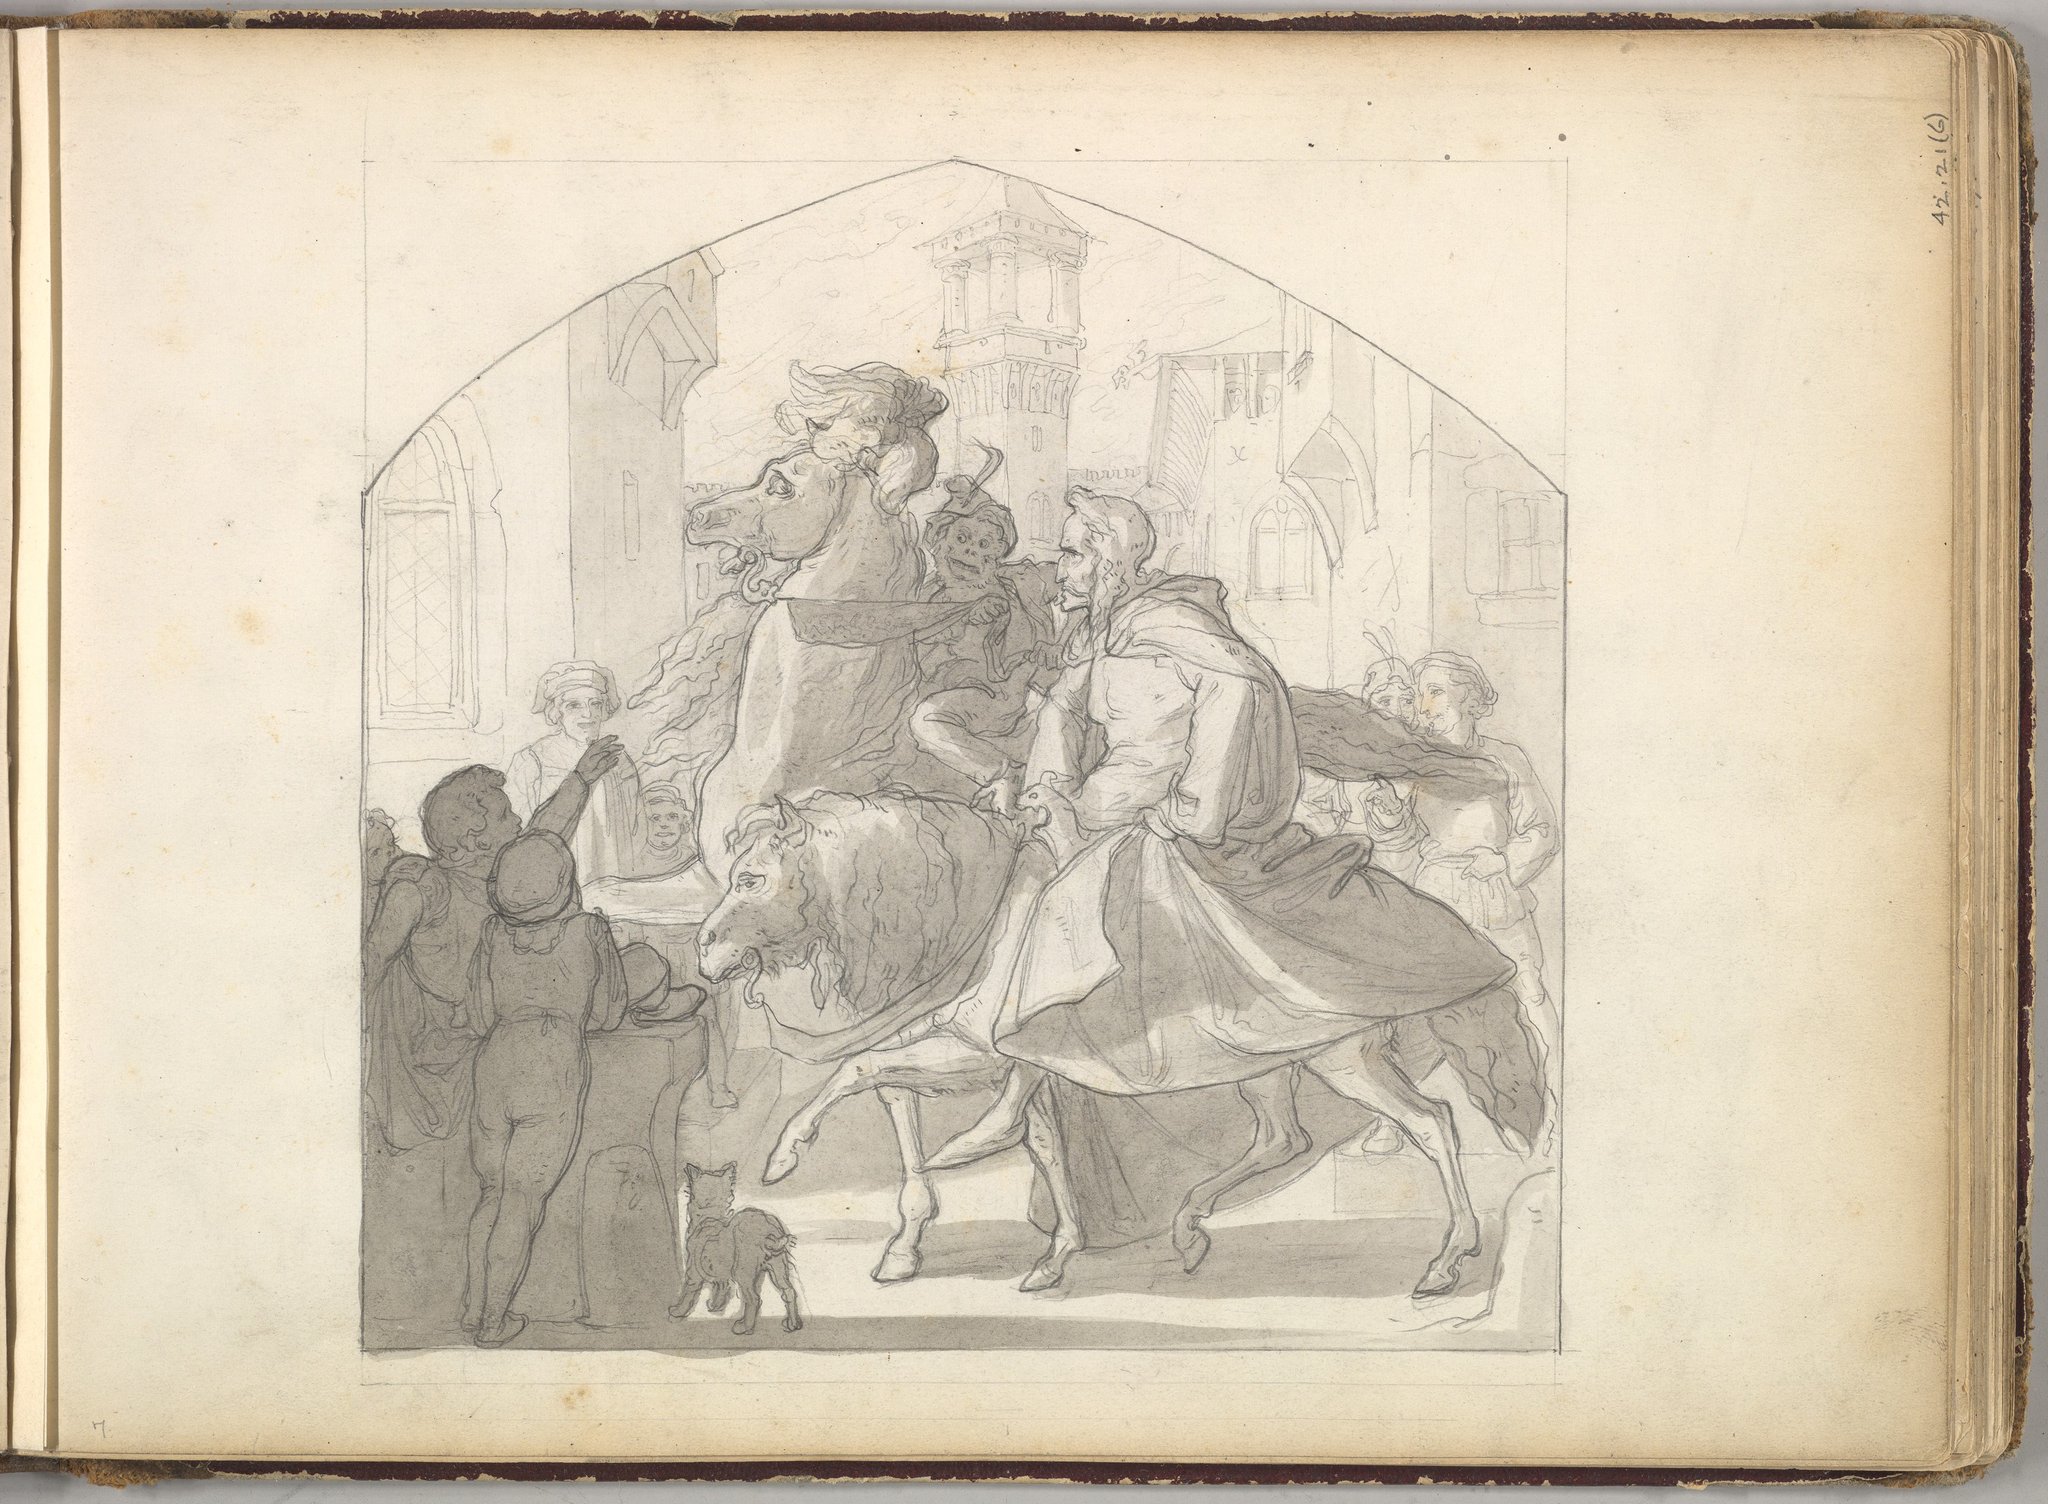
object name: drawing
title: A Man and a Monkey Riding on Horseback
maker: frederic, lord leighton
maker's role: artist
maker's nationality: british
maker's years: 1830-1896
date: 1849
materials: graphite, ink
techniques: brush, wash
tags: men,horses,monkeys